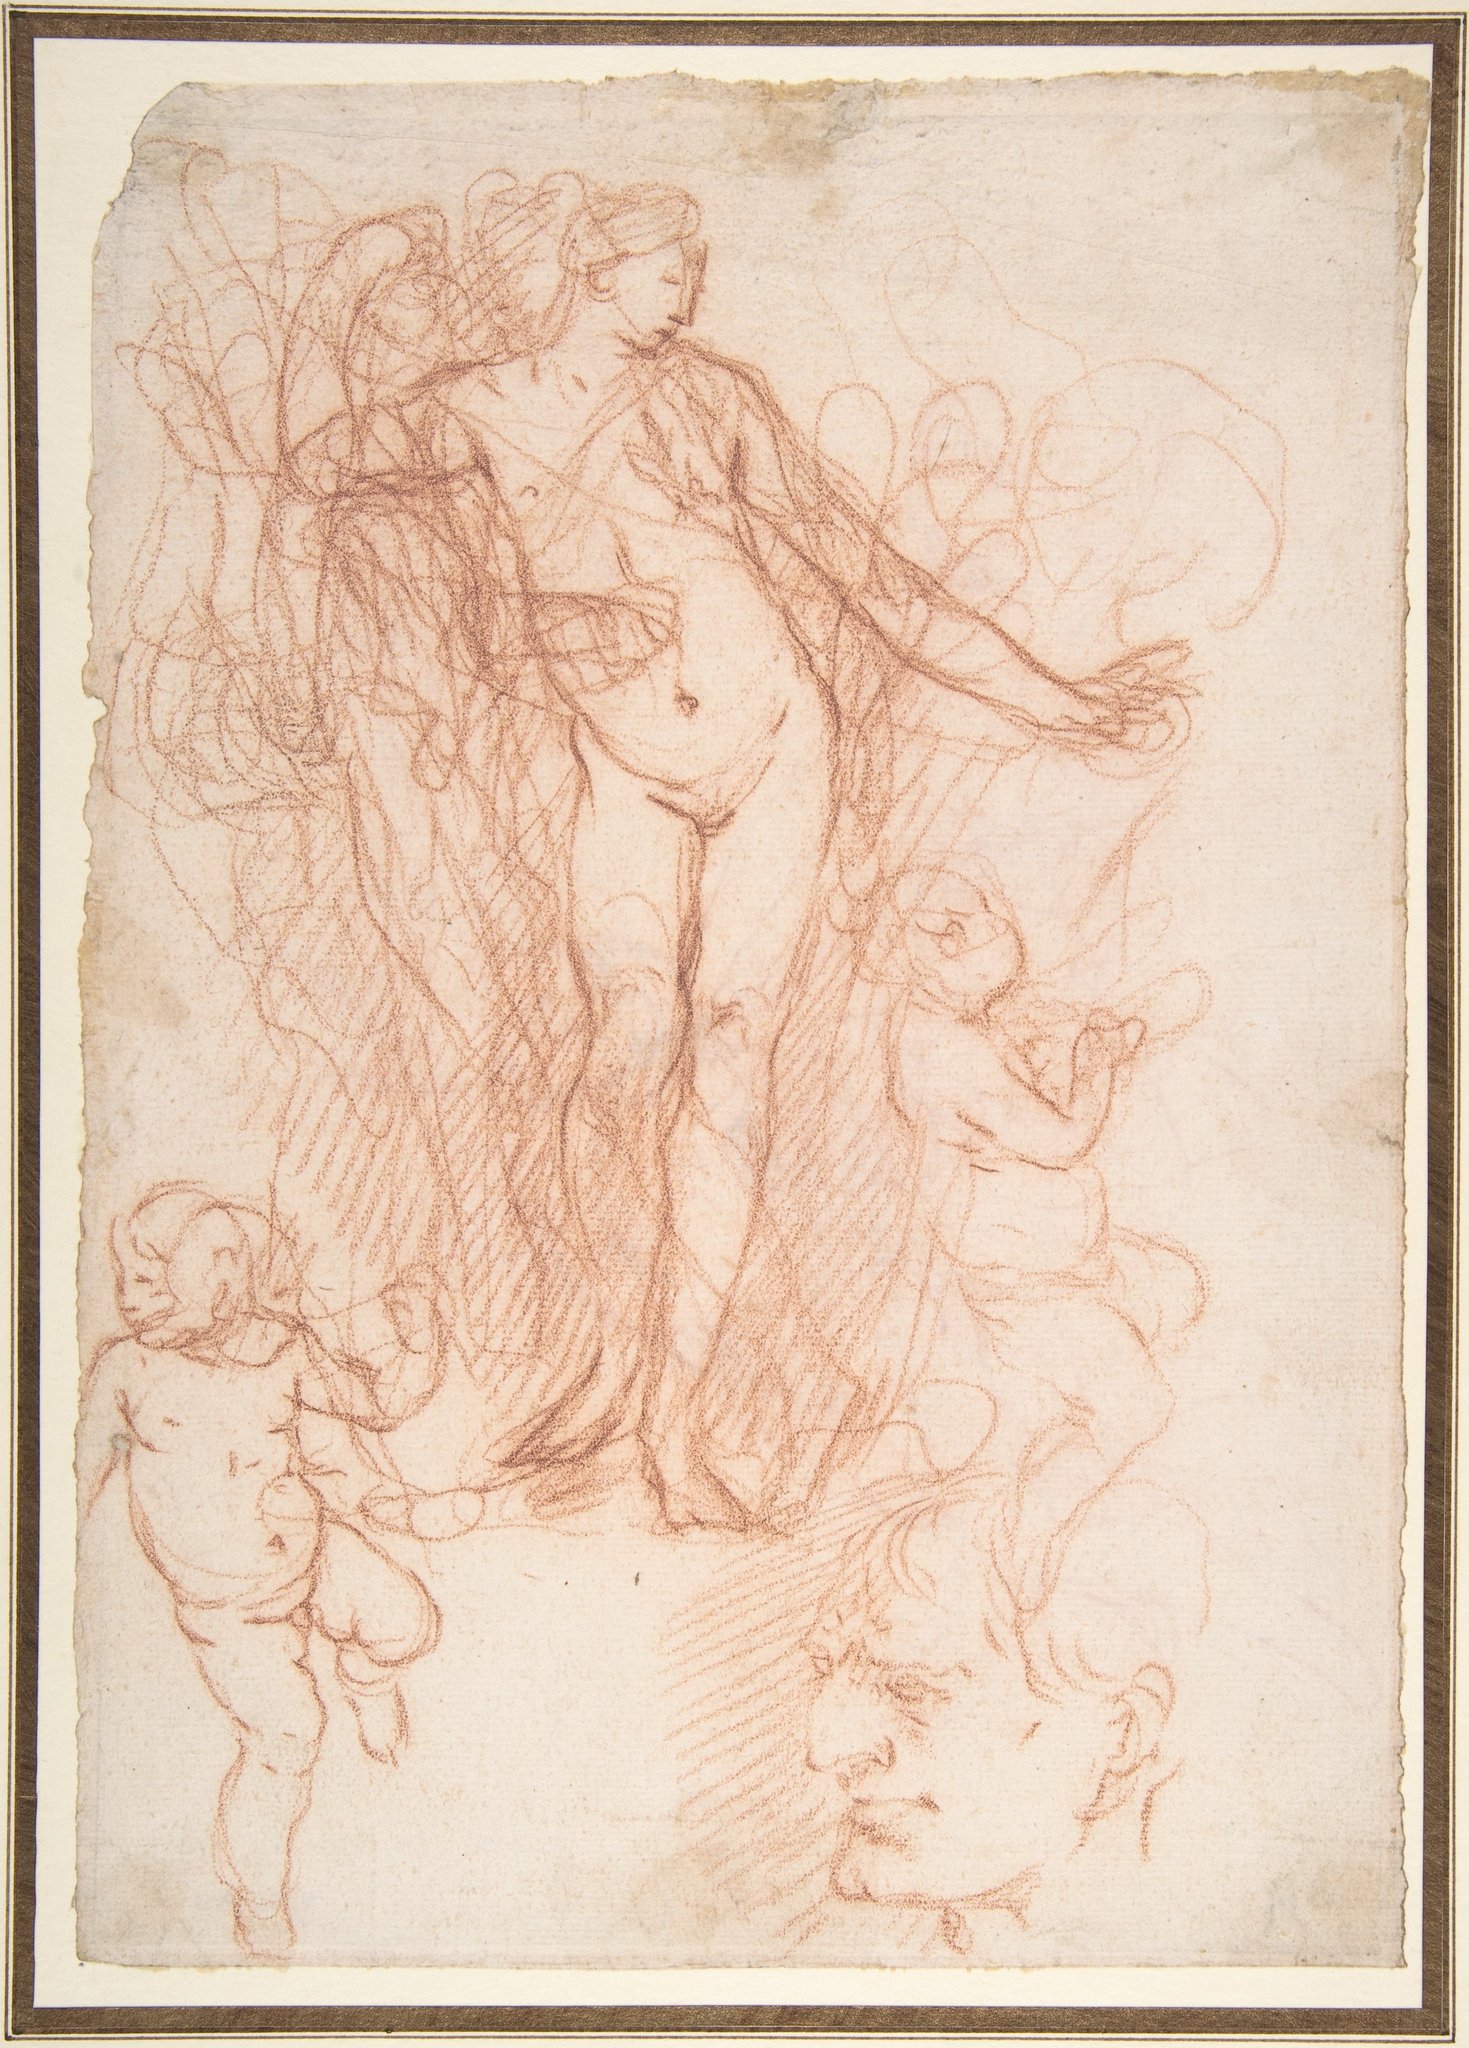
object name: drawing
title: (R.)Figure Studies: Standing Nude Figure, Putti, and a Man's Head (V.) Figure Studies: A Flying and a Standing Man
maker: giulio carpioni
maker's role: artist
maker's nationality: italian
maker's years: 1613-1678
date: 1613-1678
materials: chalk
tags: heads,men,female nudes,putti